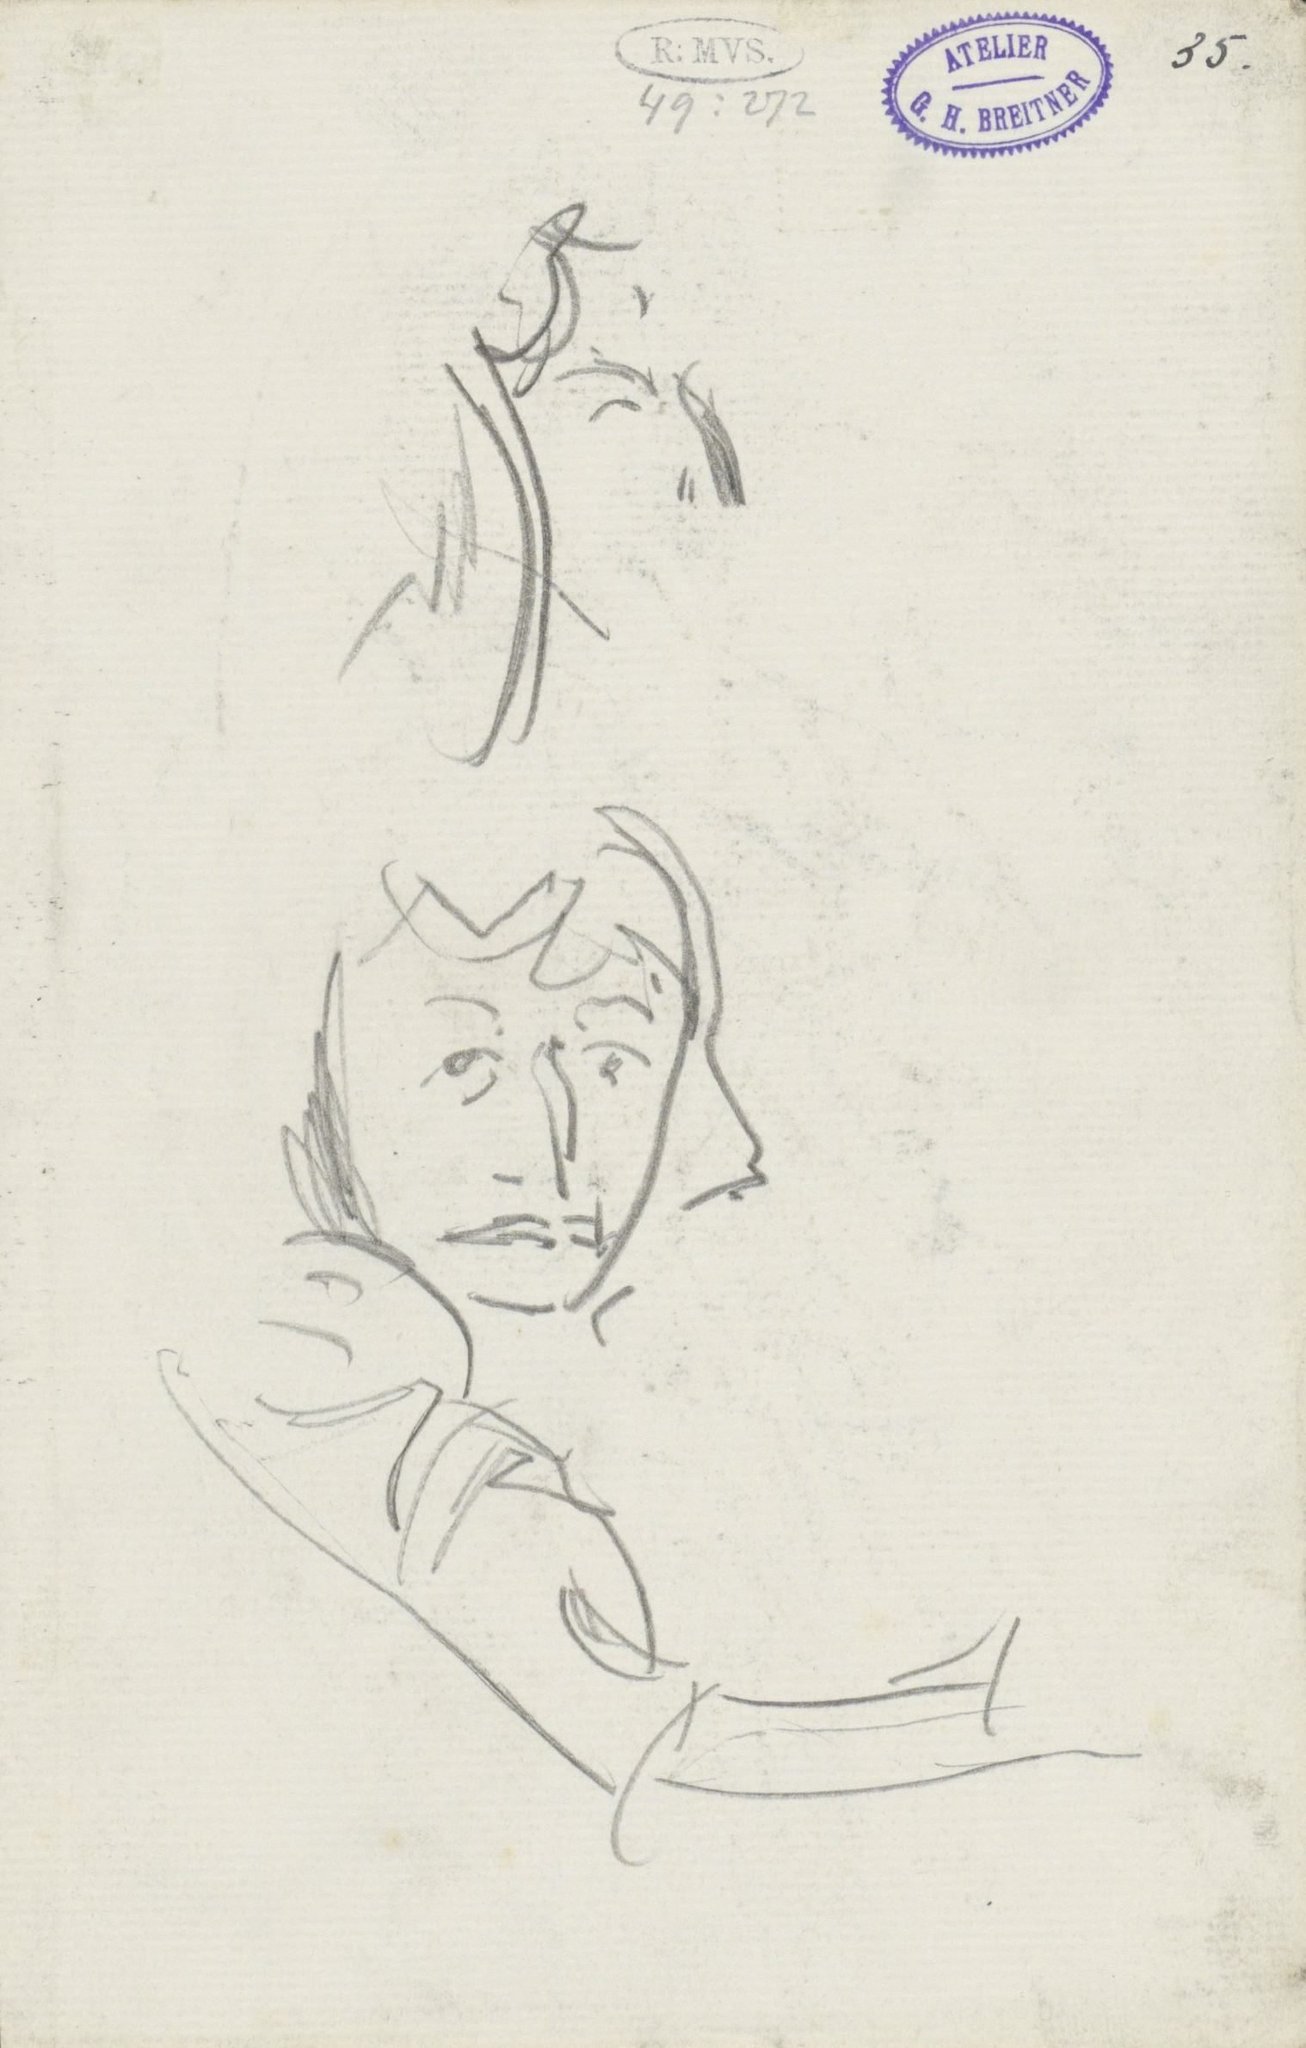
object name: drawing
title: Studies van een vrouw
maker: george hendrik breitner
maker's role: draughtsman, painter, print maker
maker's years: 1857-1923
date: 1886-1923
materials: paper, pencil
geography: amsterdam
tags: adult woman, head (human) - aa - female human figure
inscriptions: workshop stamp: Lugt 291d, collector's mark: Lugt 2228